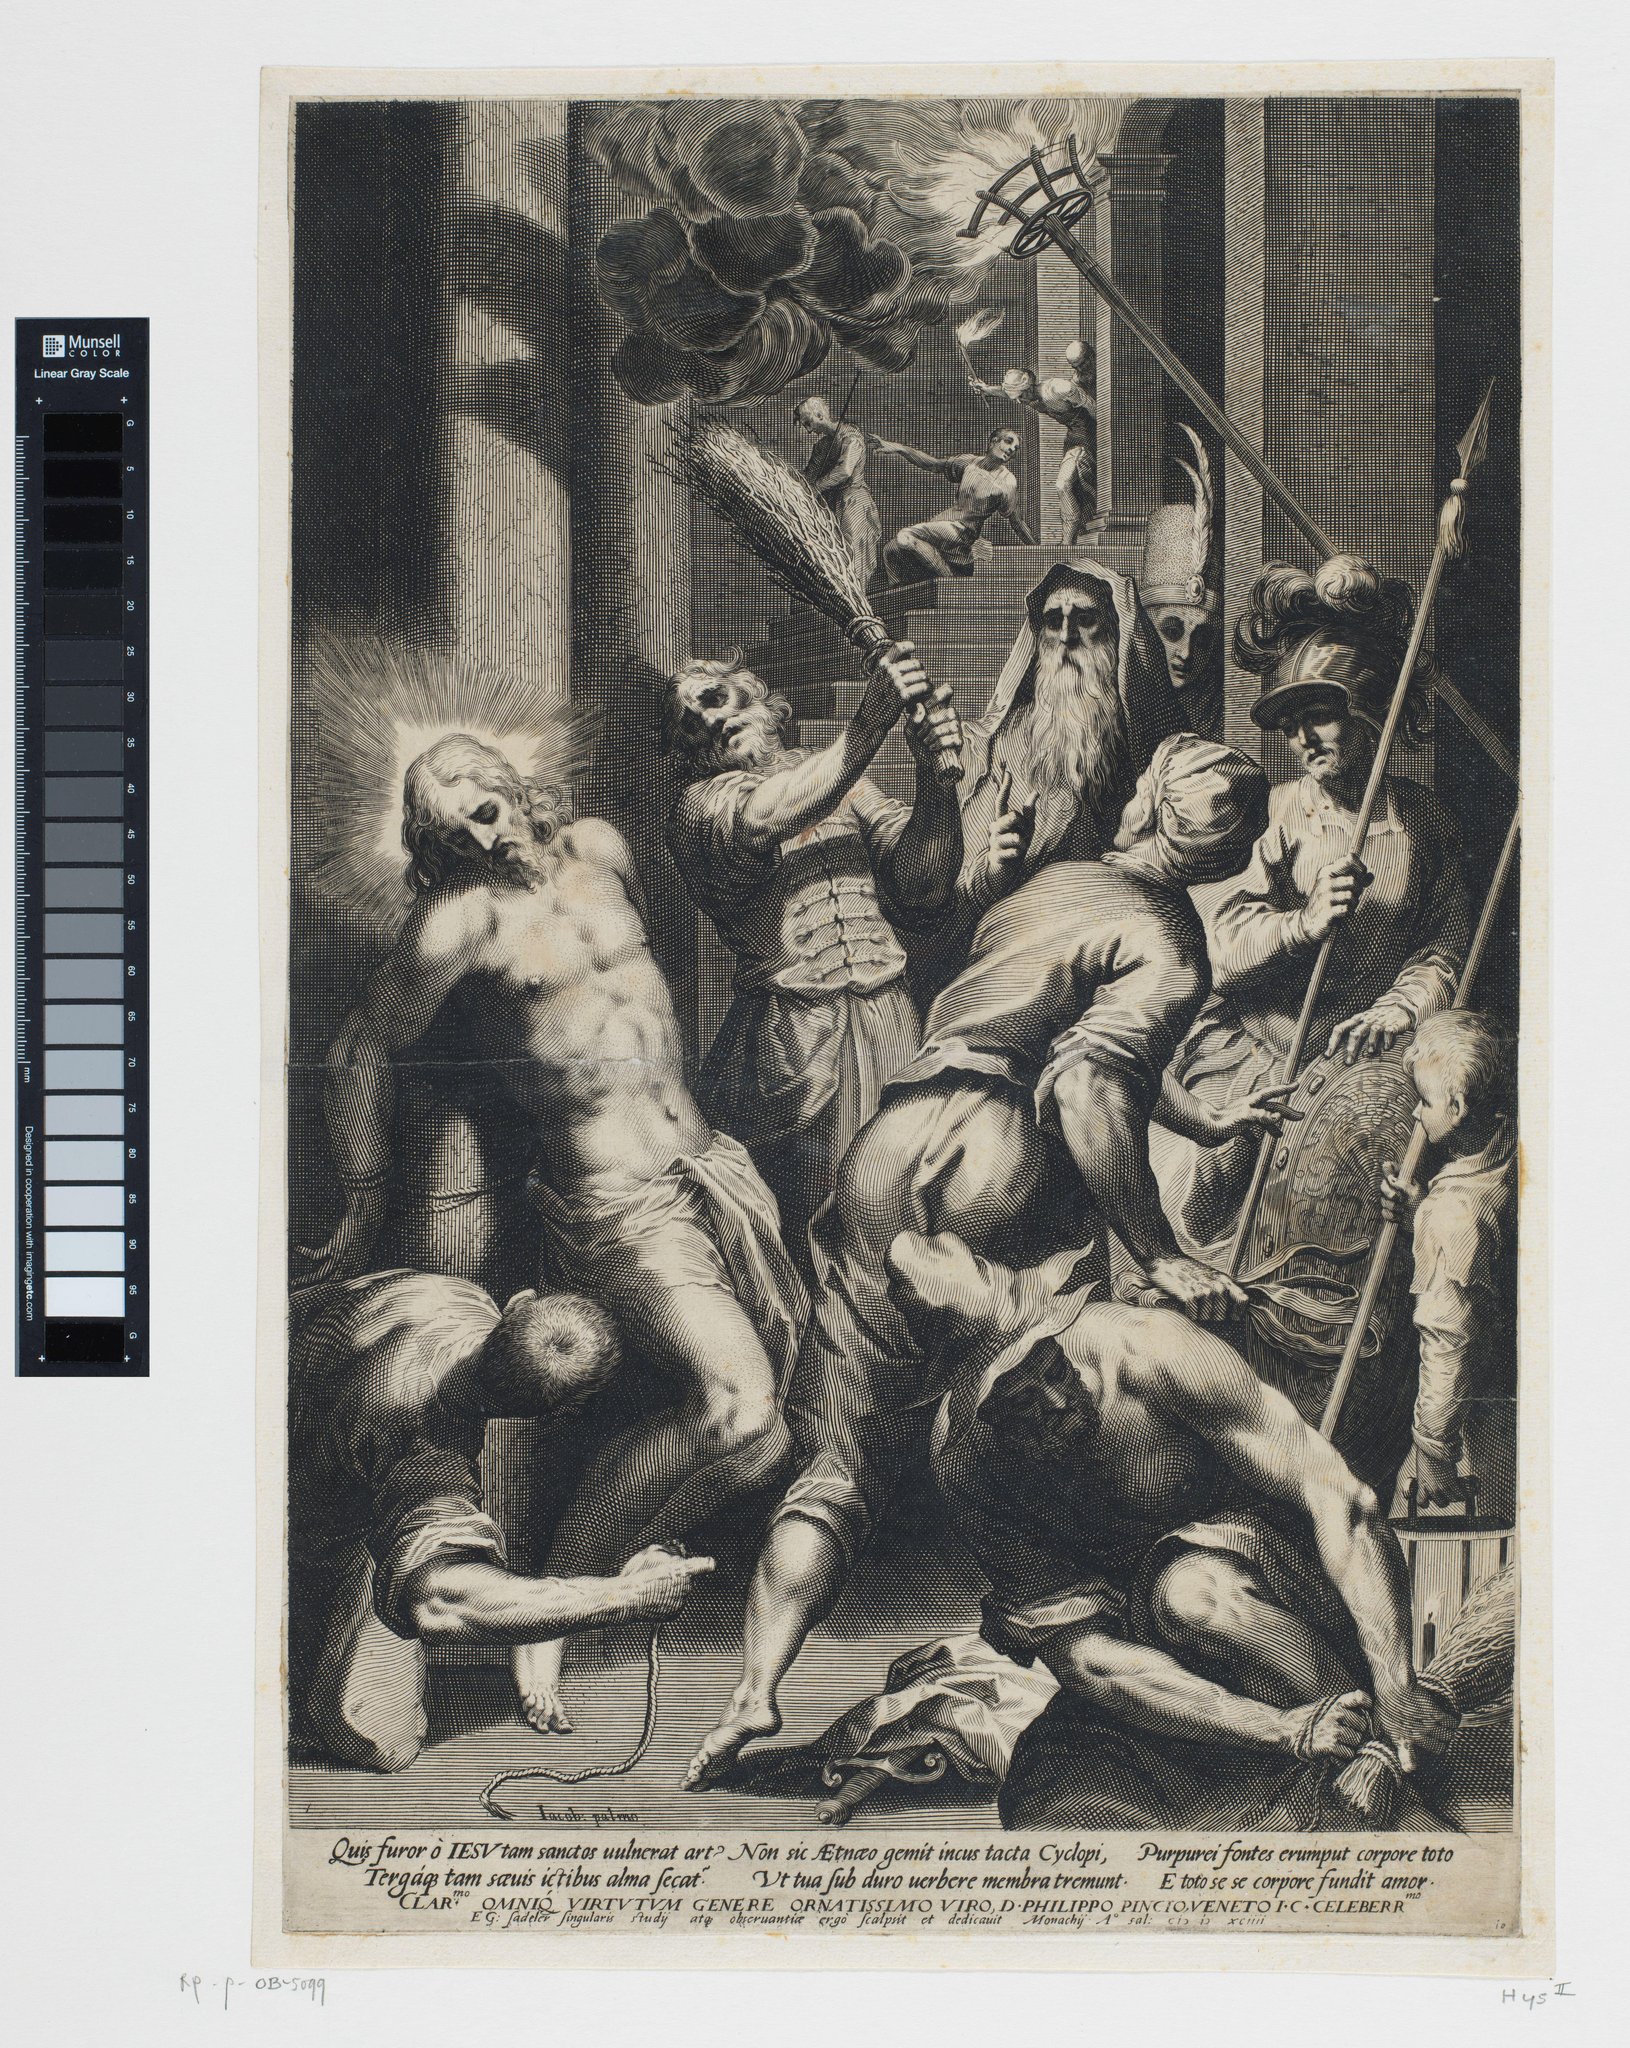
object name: print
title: Geseling van Christus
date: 1594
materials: paper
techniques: engraving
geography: munich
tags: flagellation by soldiers, christ usually tied to a column (matthew 27:26; mark 15:15; john 19:1)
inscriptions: collector's mark: Lugt 240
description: Christus, vastgebonden aan een pilaar, wordt door soldaten gegeseld. De prent heeft een Latijns onderschrift.